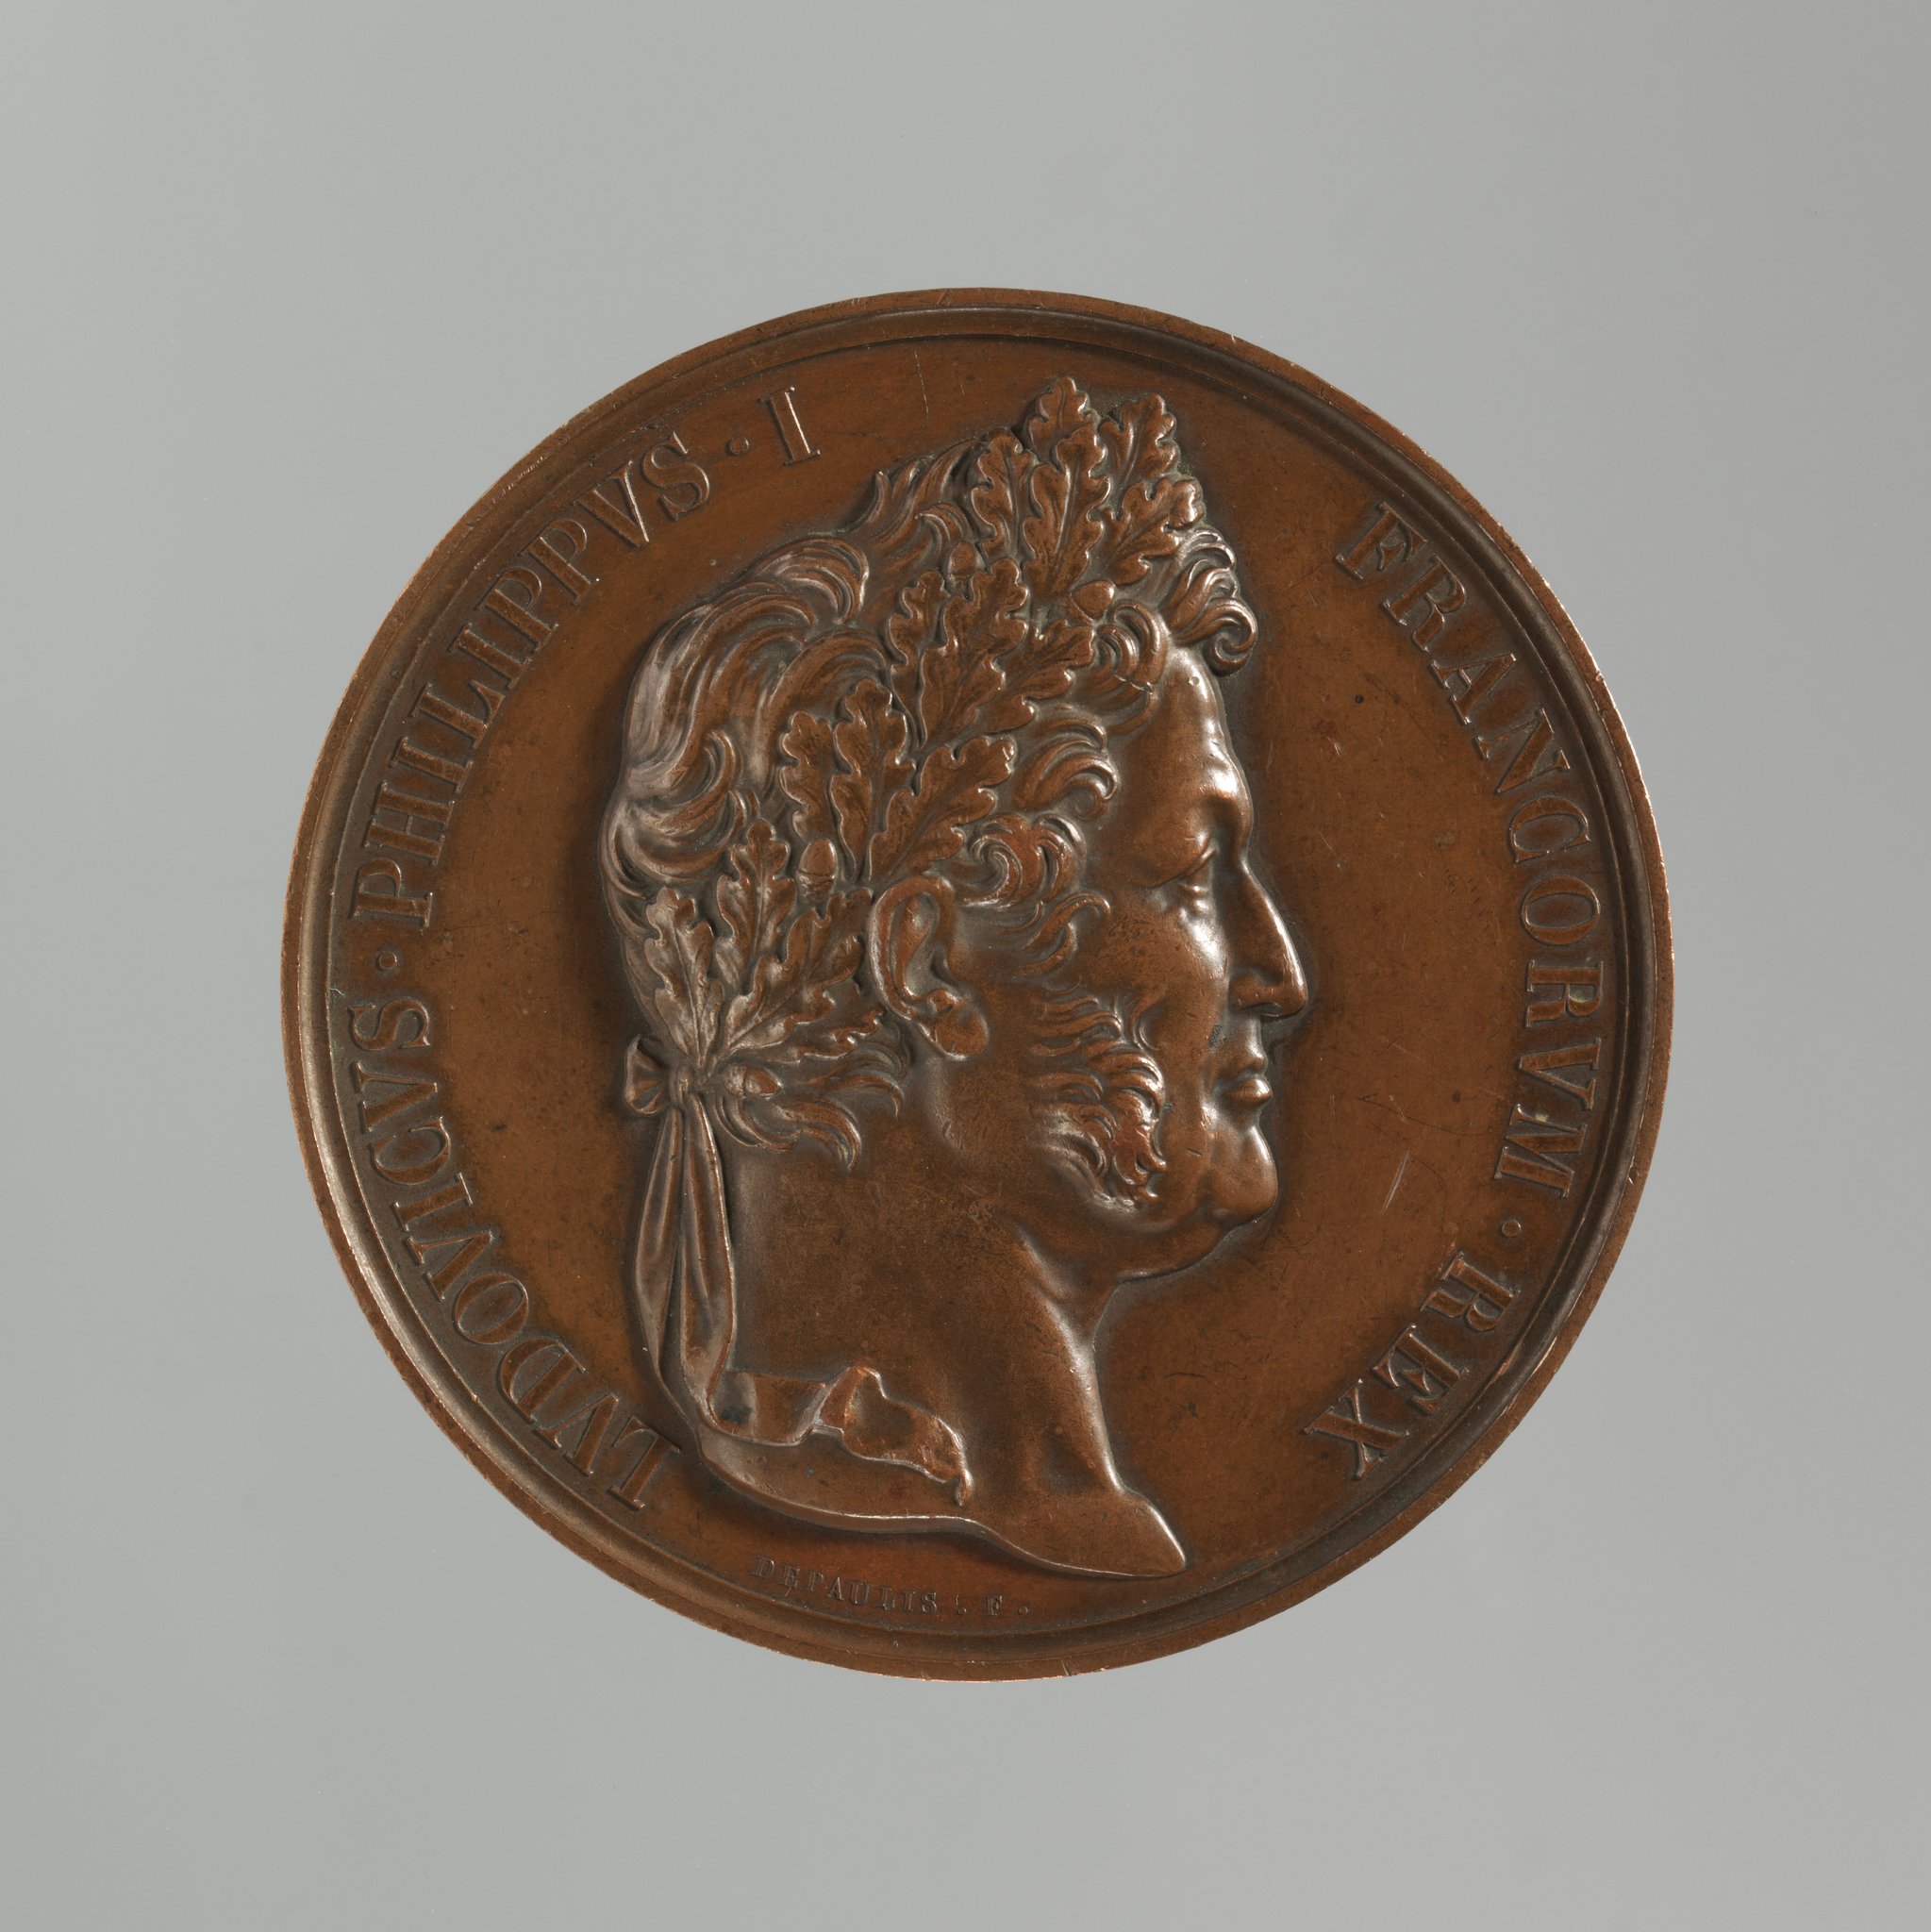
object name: medal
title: Concordiae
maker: alexis joseph depaulis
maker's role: artist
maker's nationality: french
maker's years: 1790-1867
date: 1830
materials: bronze